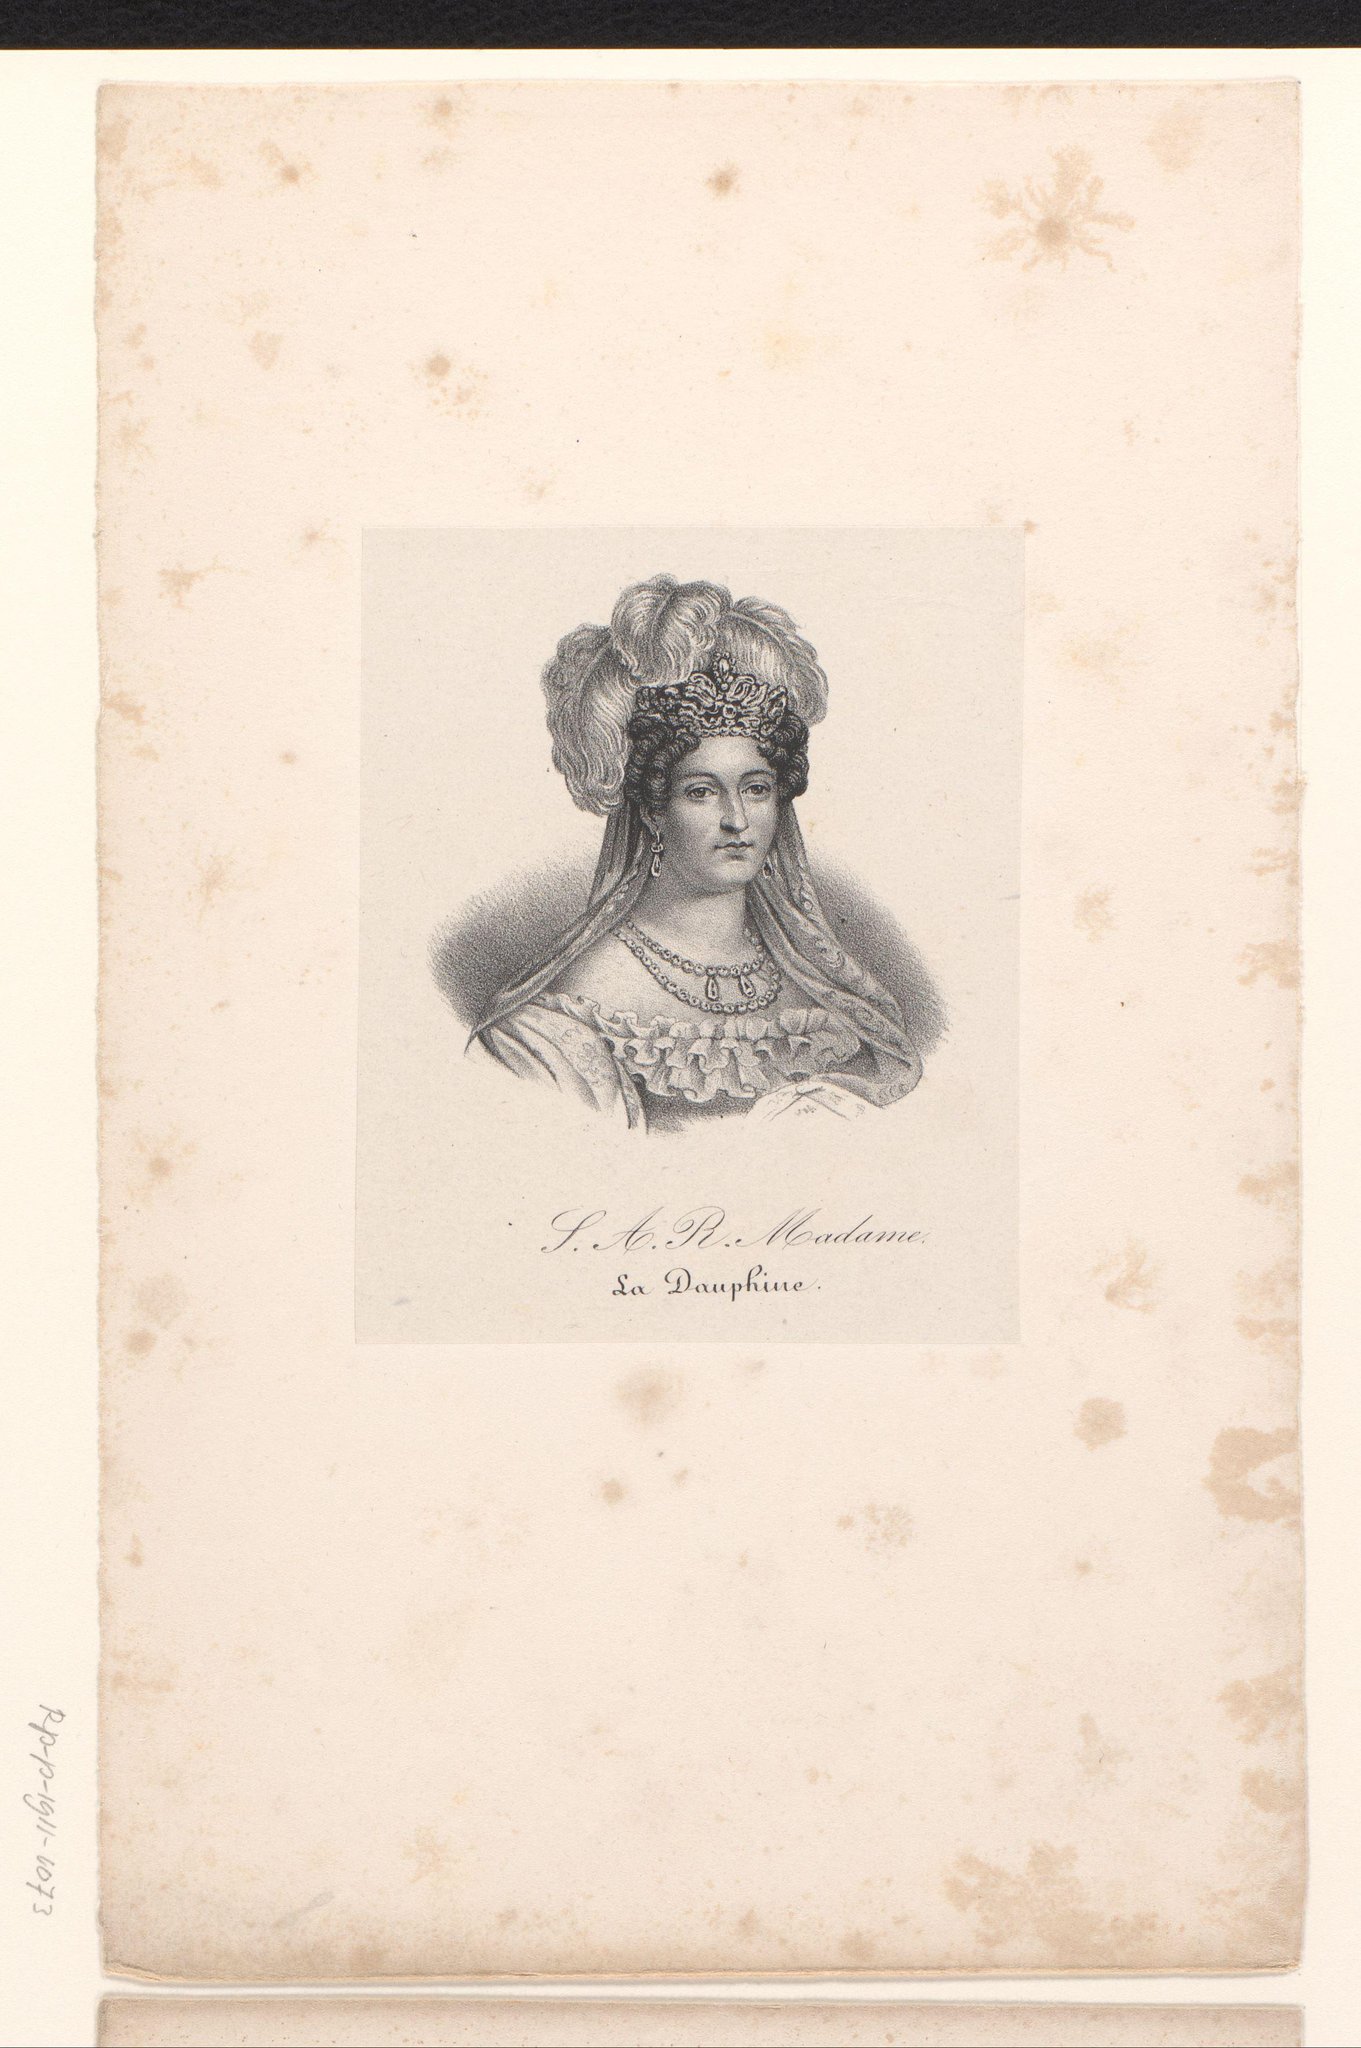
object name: print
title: S.A.R. Madame la Daupine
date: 1818-1842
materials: paper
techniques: lithograph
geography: paris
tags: vienna, marie thérèse charlotte van frankrijk, historical persons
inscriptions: collector's mark: Lugt 2228a